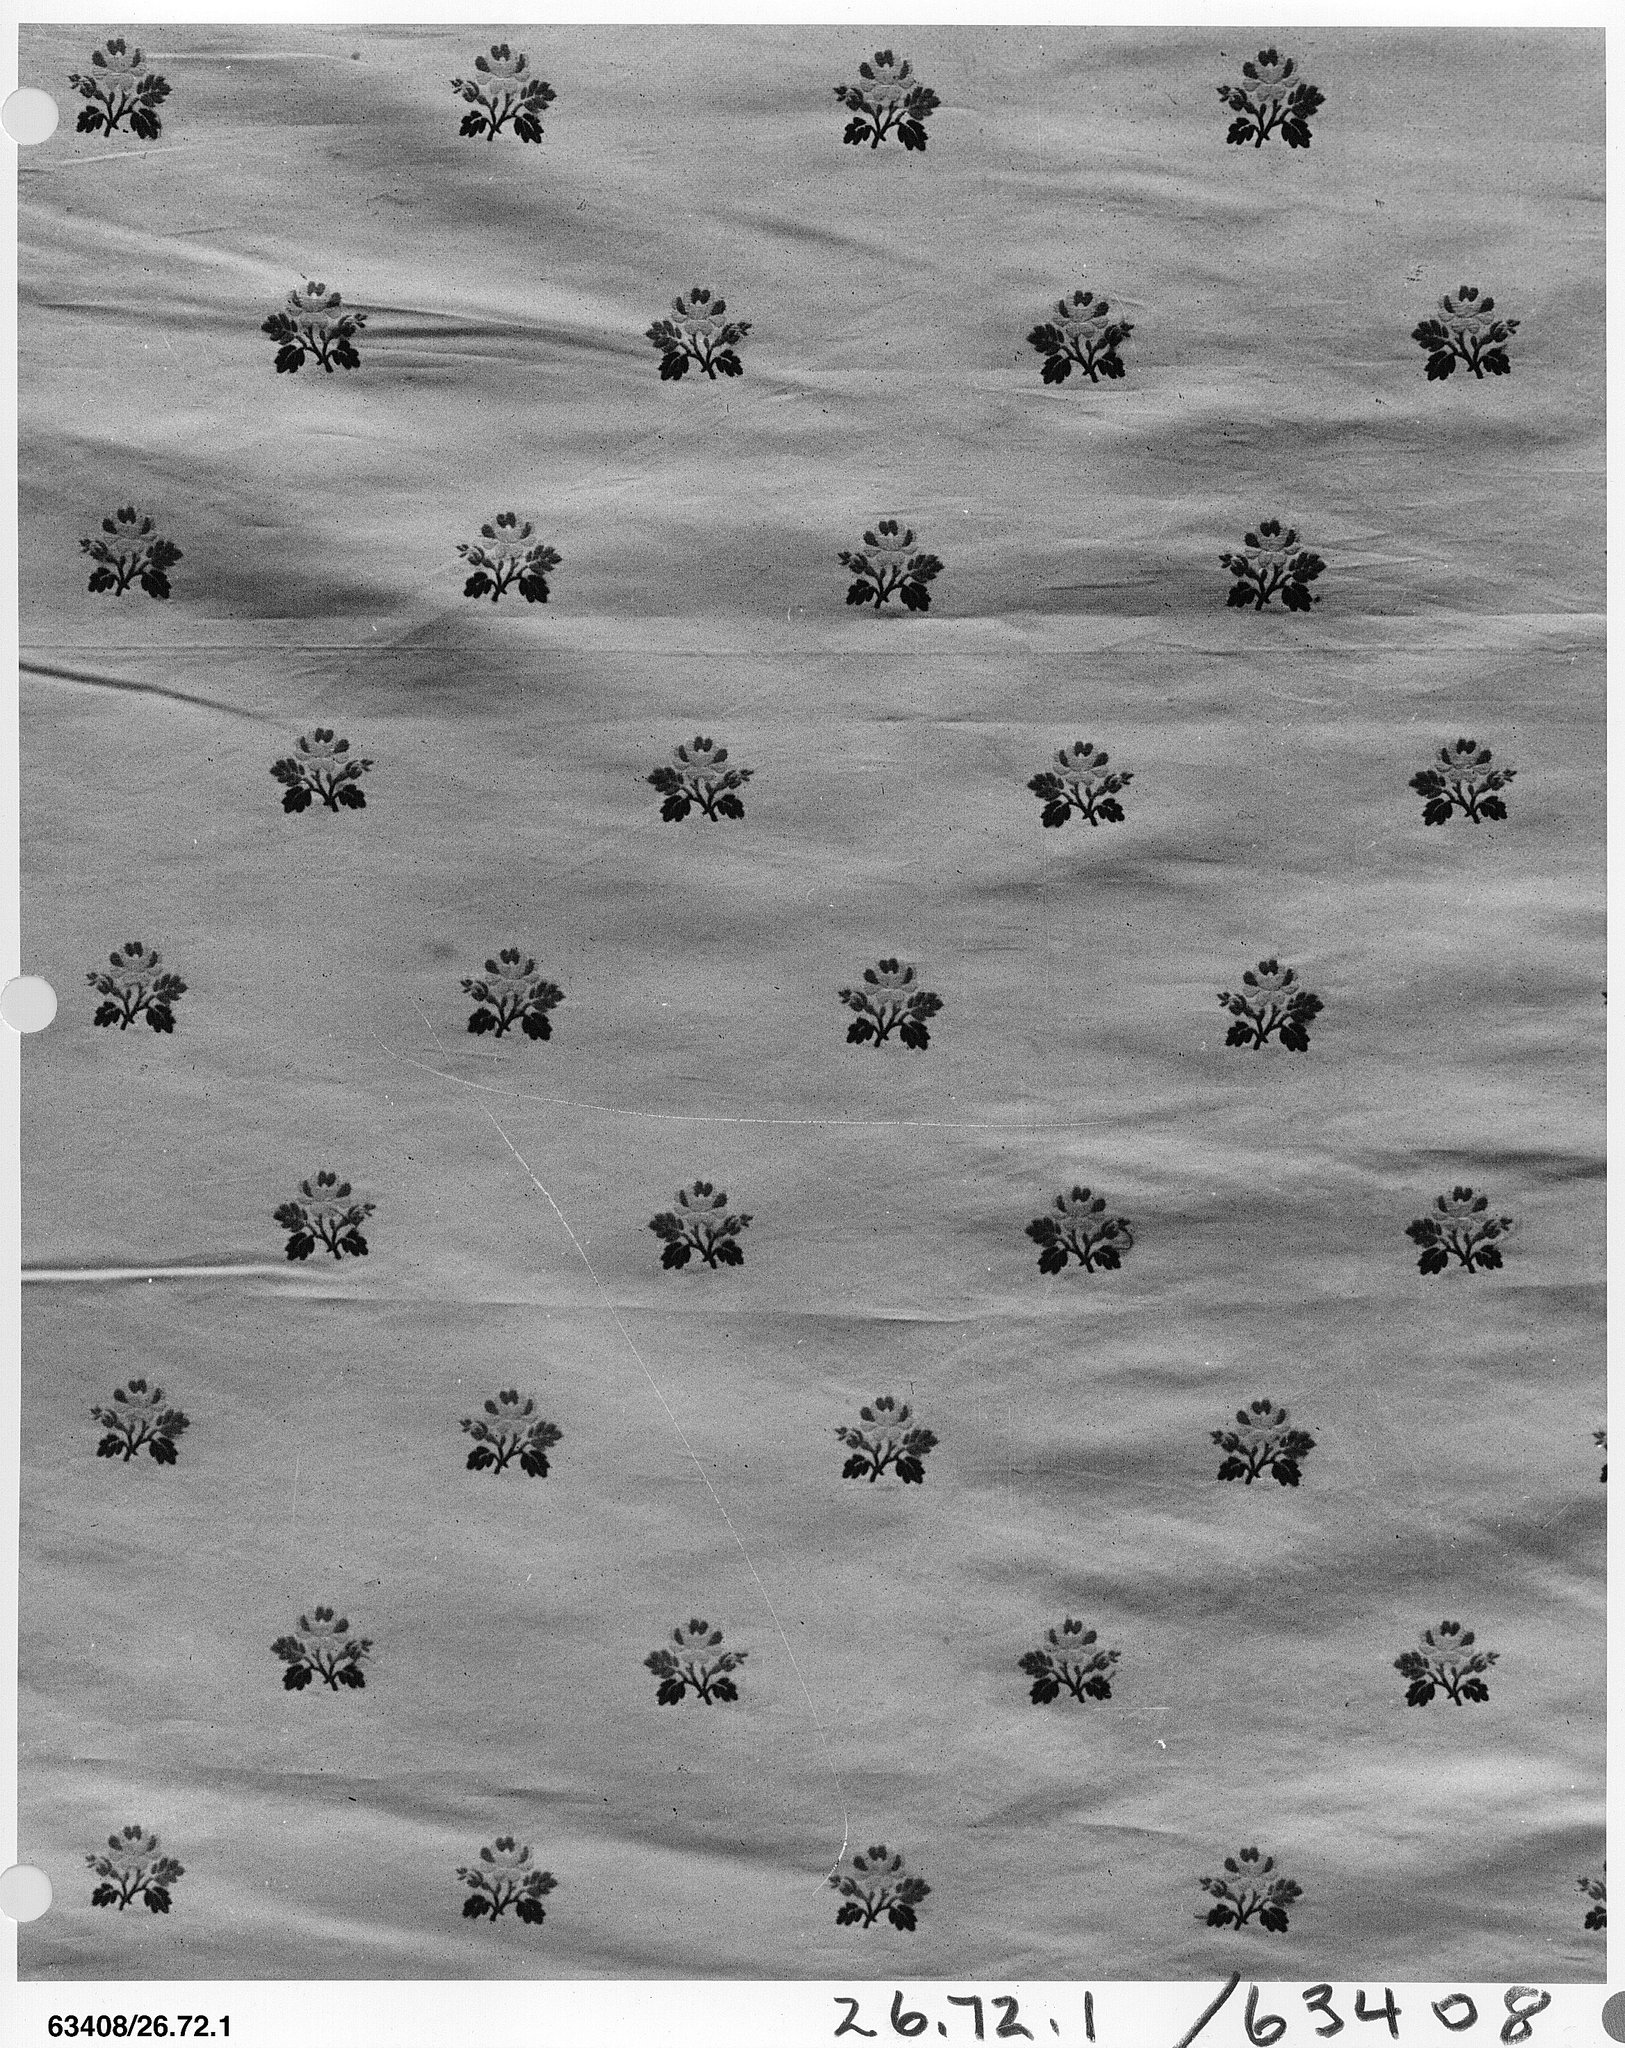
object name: fragment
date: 1887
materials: silk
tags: flowers,leaves